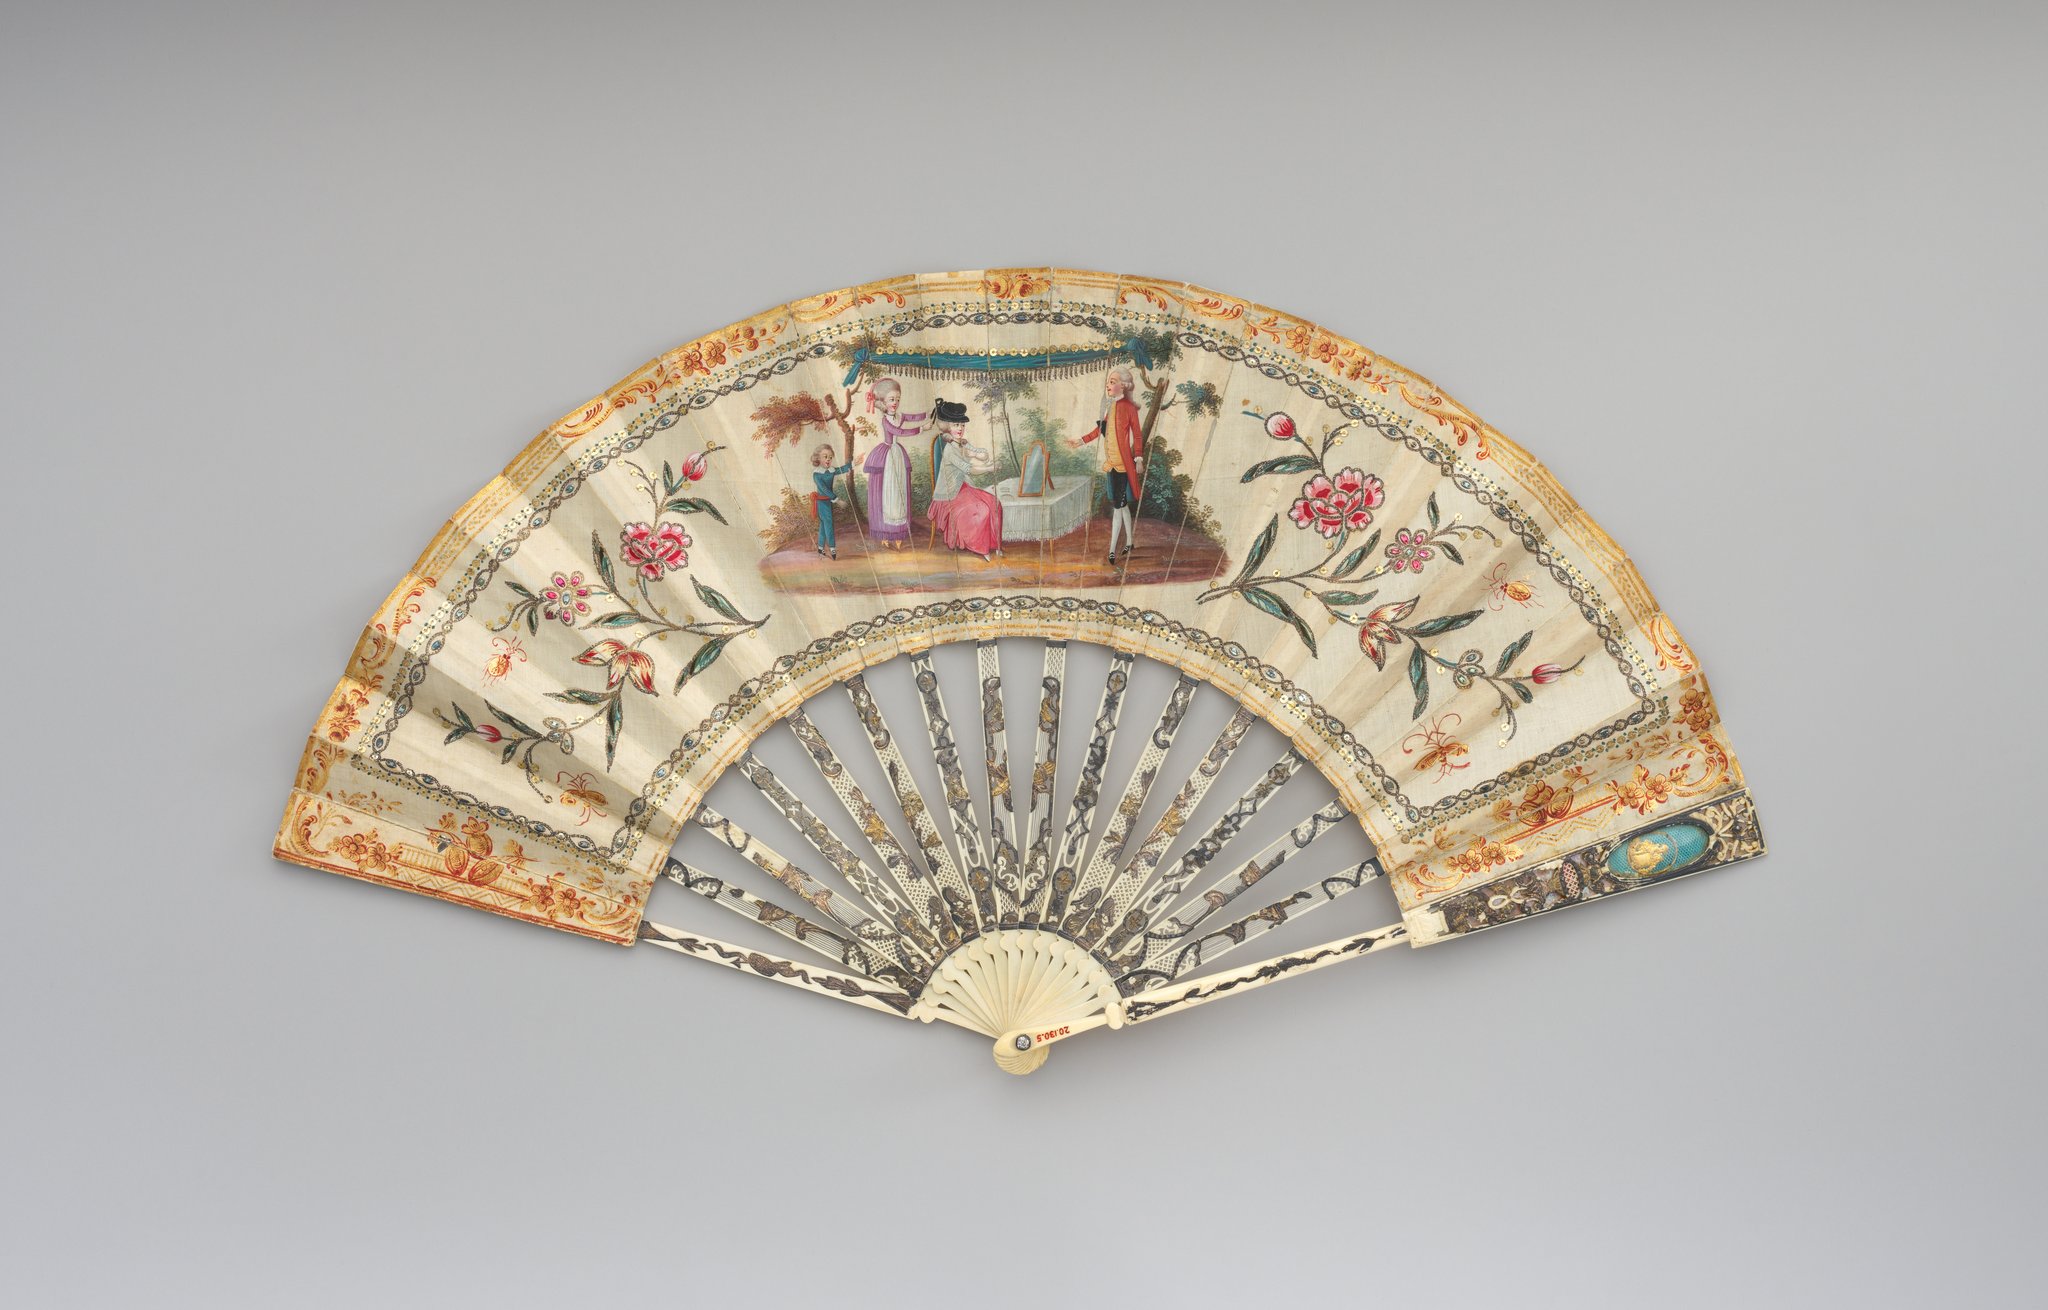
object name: fan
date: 1780-1785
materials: gilt, ivory, paint, paper, thread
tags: men,women,mirrors